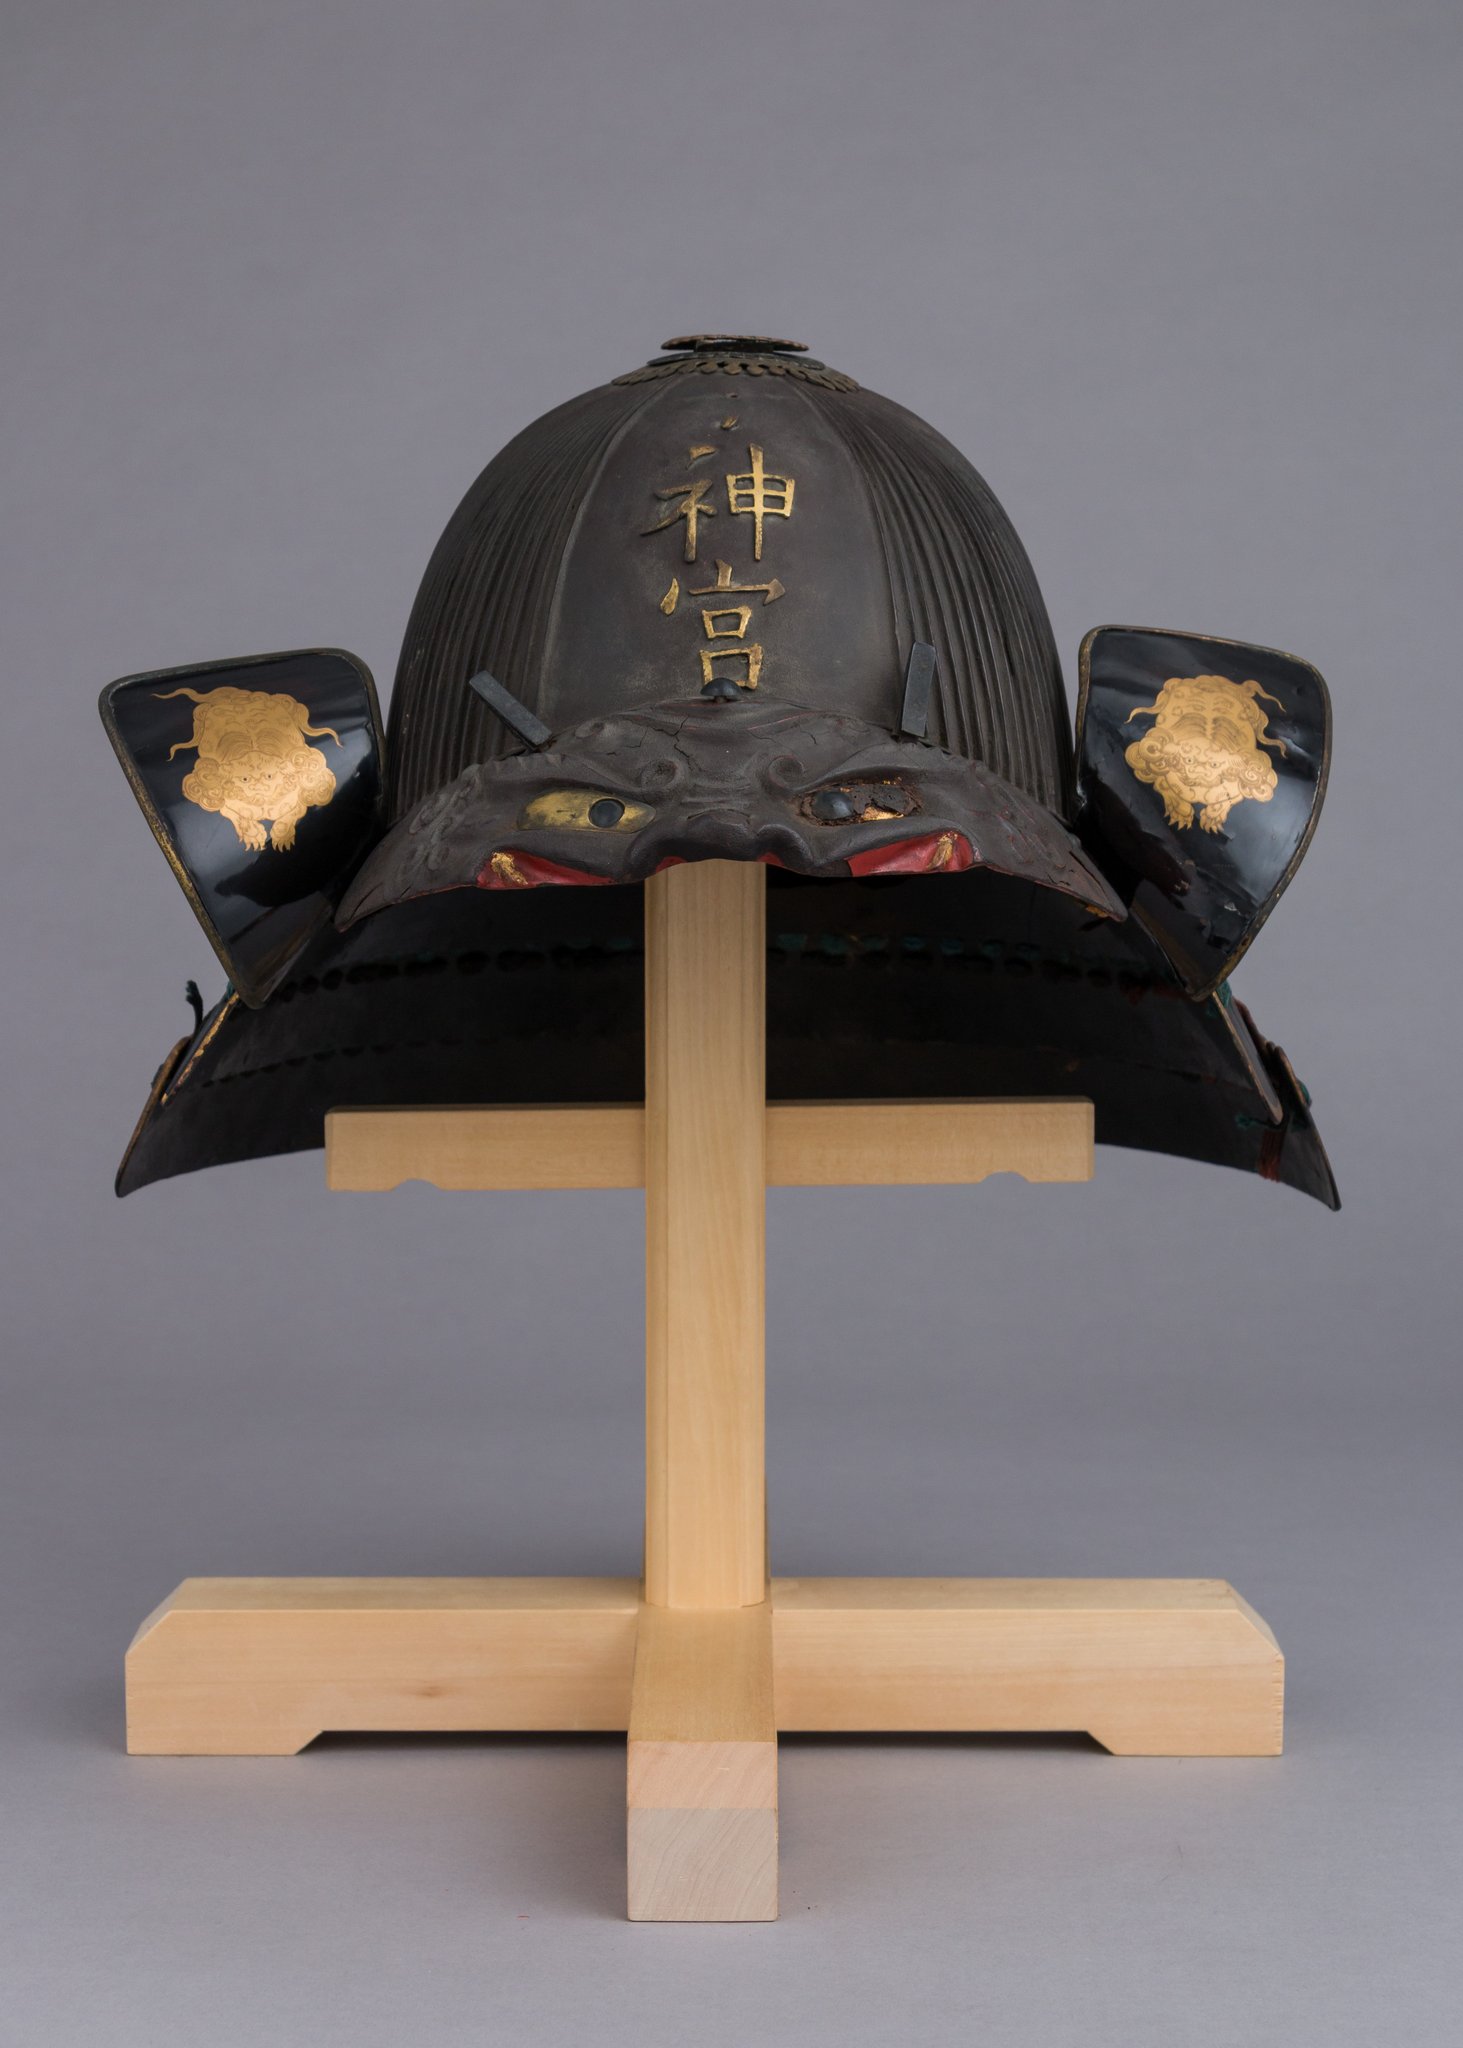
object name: helmet kabuto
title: Helmet (Suji-Kabuto)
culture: japanese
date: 1667-1733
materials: copper, gold alloy, gold, iron, lacquer, silk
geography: japan